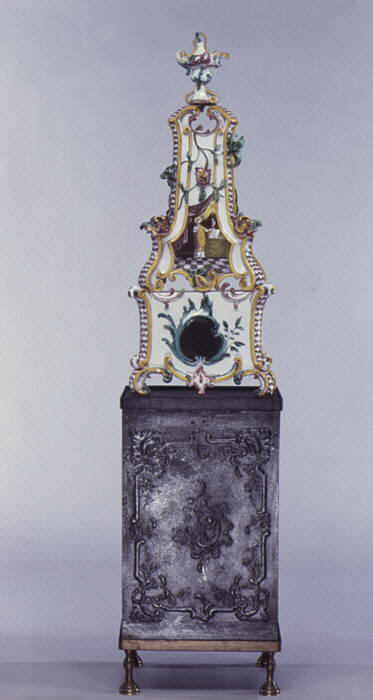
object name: stove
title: Ceramic stove on cast-iron firebox (one of a pair)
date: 1773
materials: earthenware, gilt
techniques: glazing